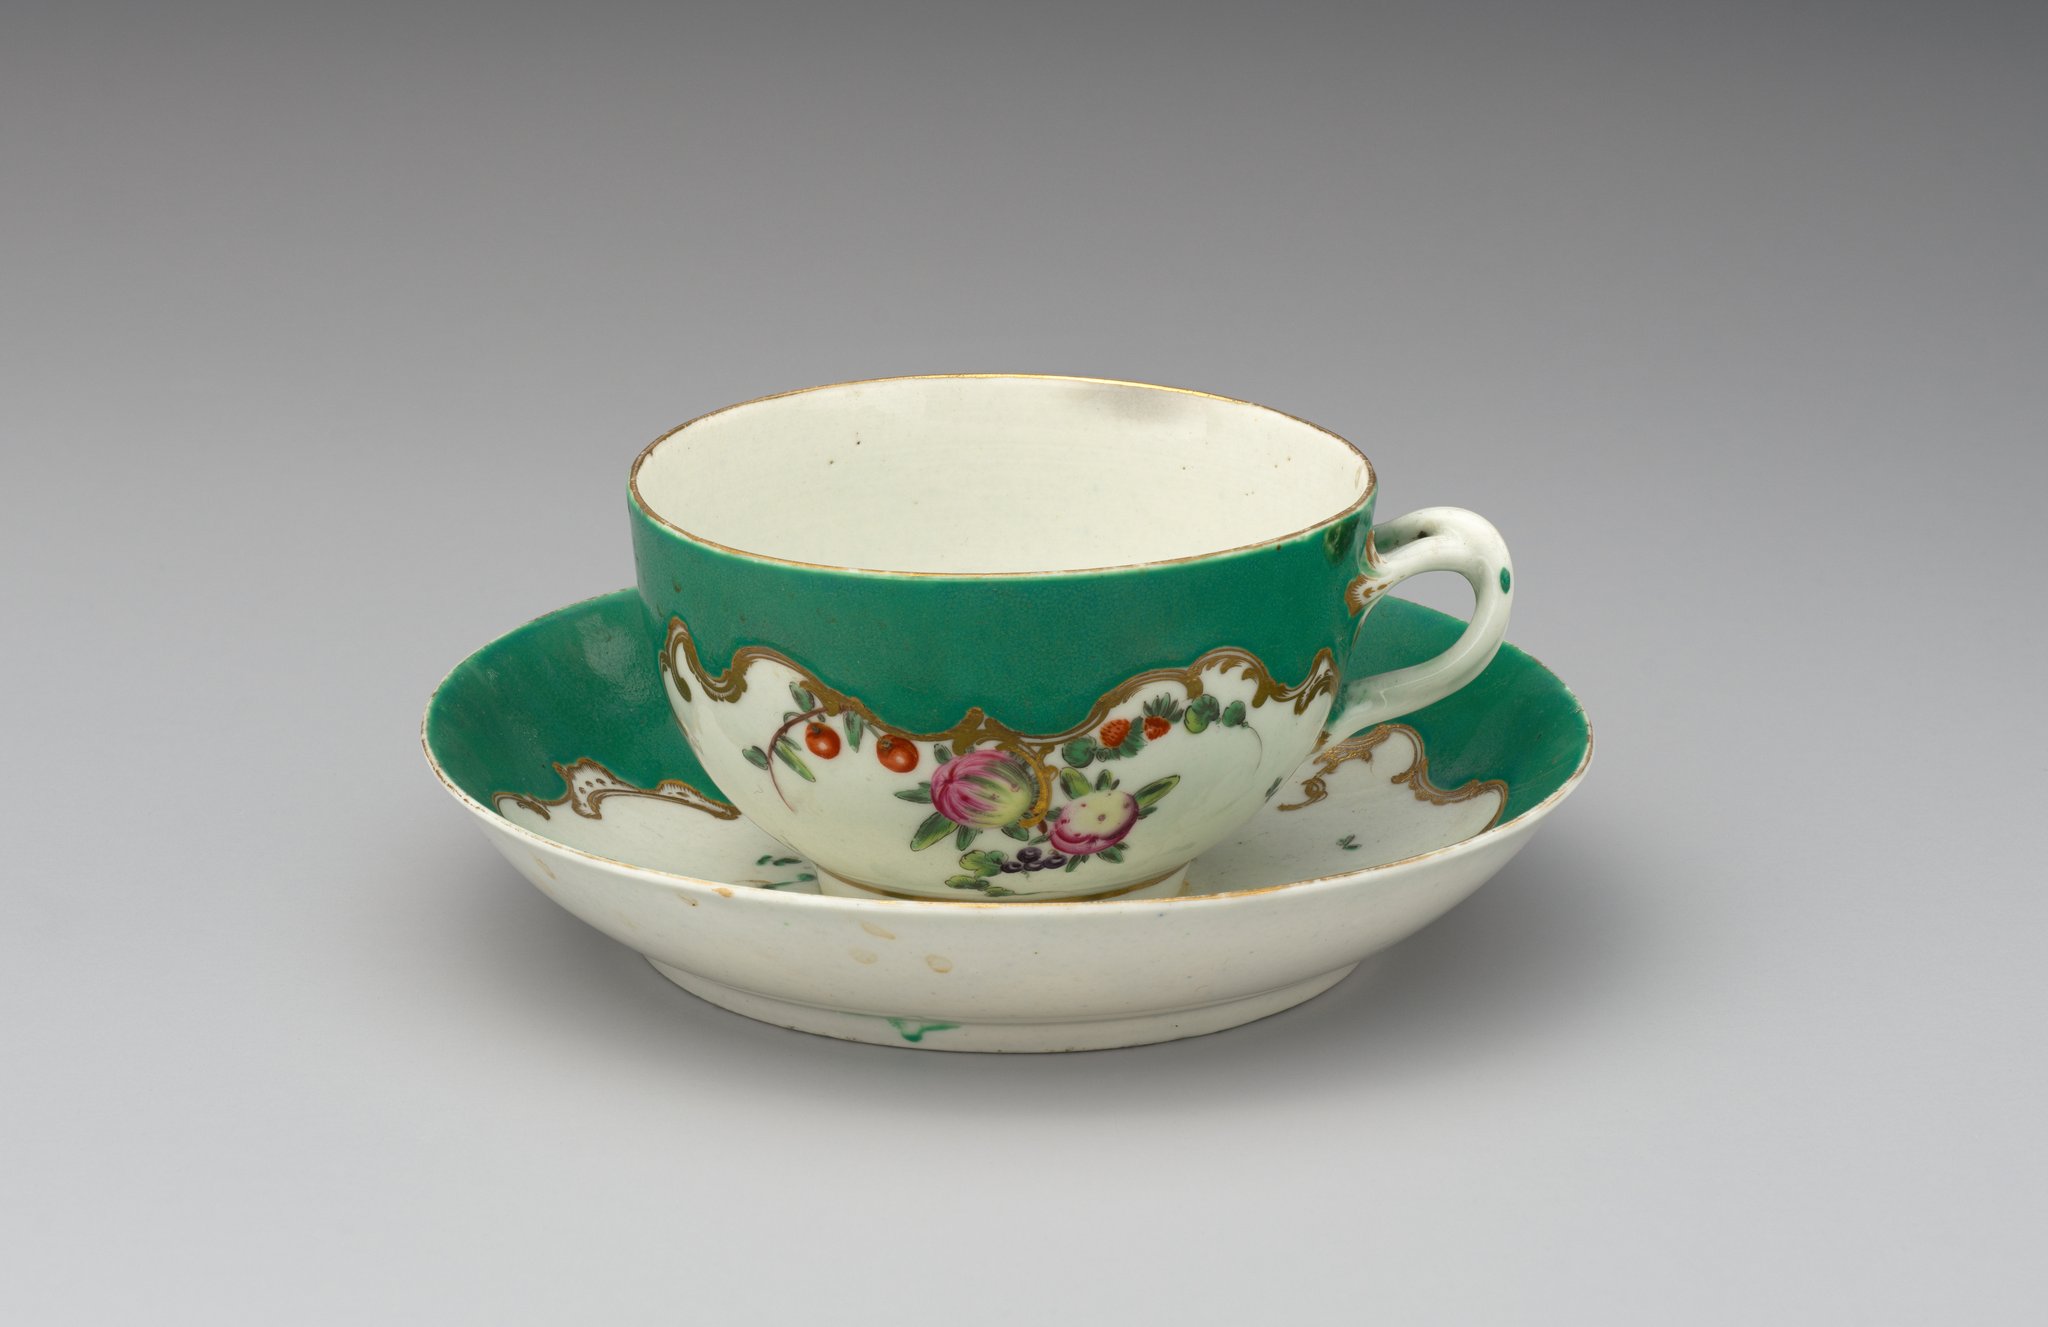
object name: cup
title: Cup (part of a service)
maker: worcester factory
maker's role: factory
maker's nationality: british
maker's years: 1751-2008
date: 1770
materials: soft paste porcelain